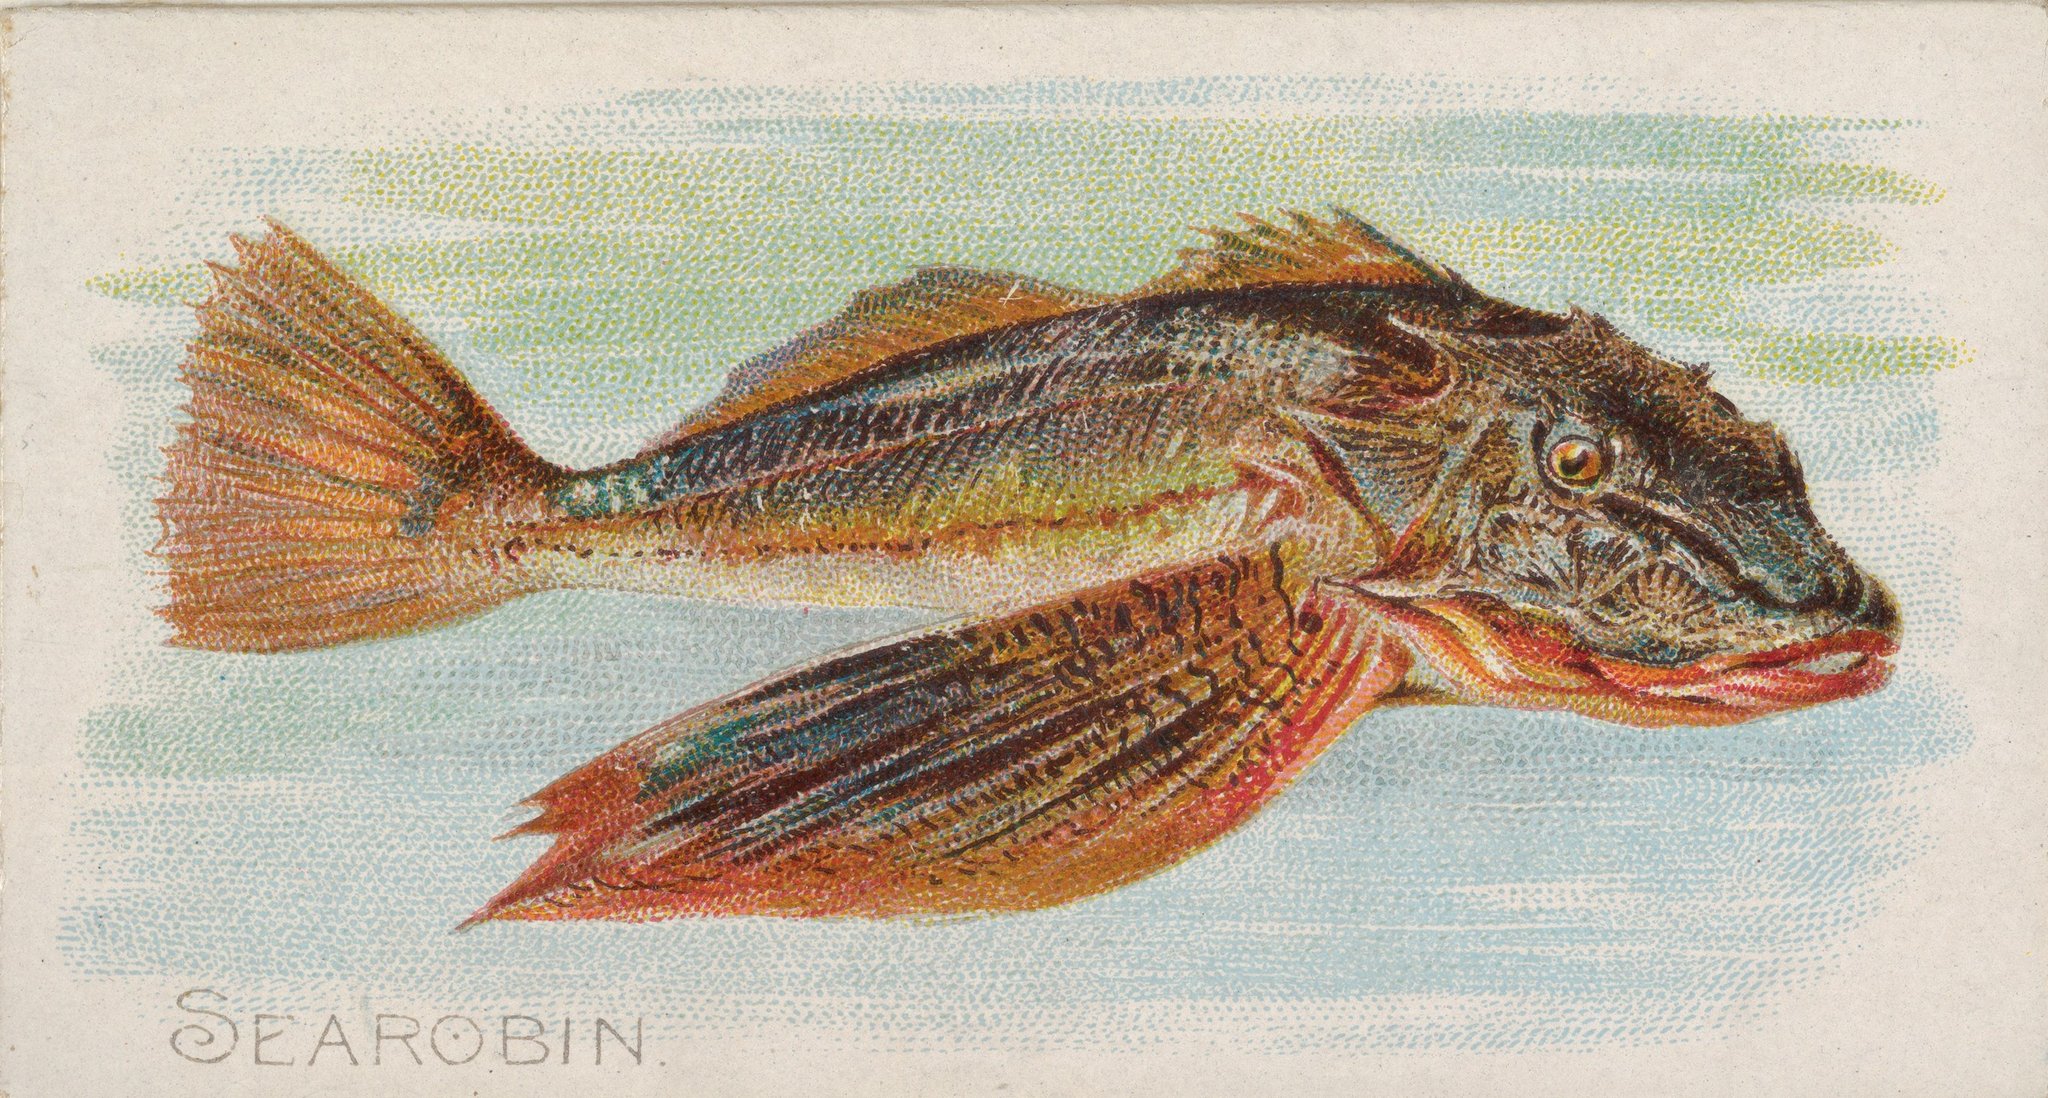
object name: print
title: Sea Robin, from the Fish from American Waters series (N8) for Allen & Ginter Cigarettes Brands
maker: allen & ginter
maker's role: publisher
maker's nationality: american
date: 1889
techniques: color lithograph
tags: fish